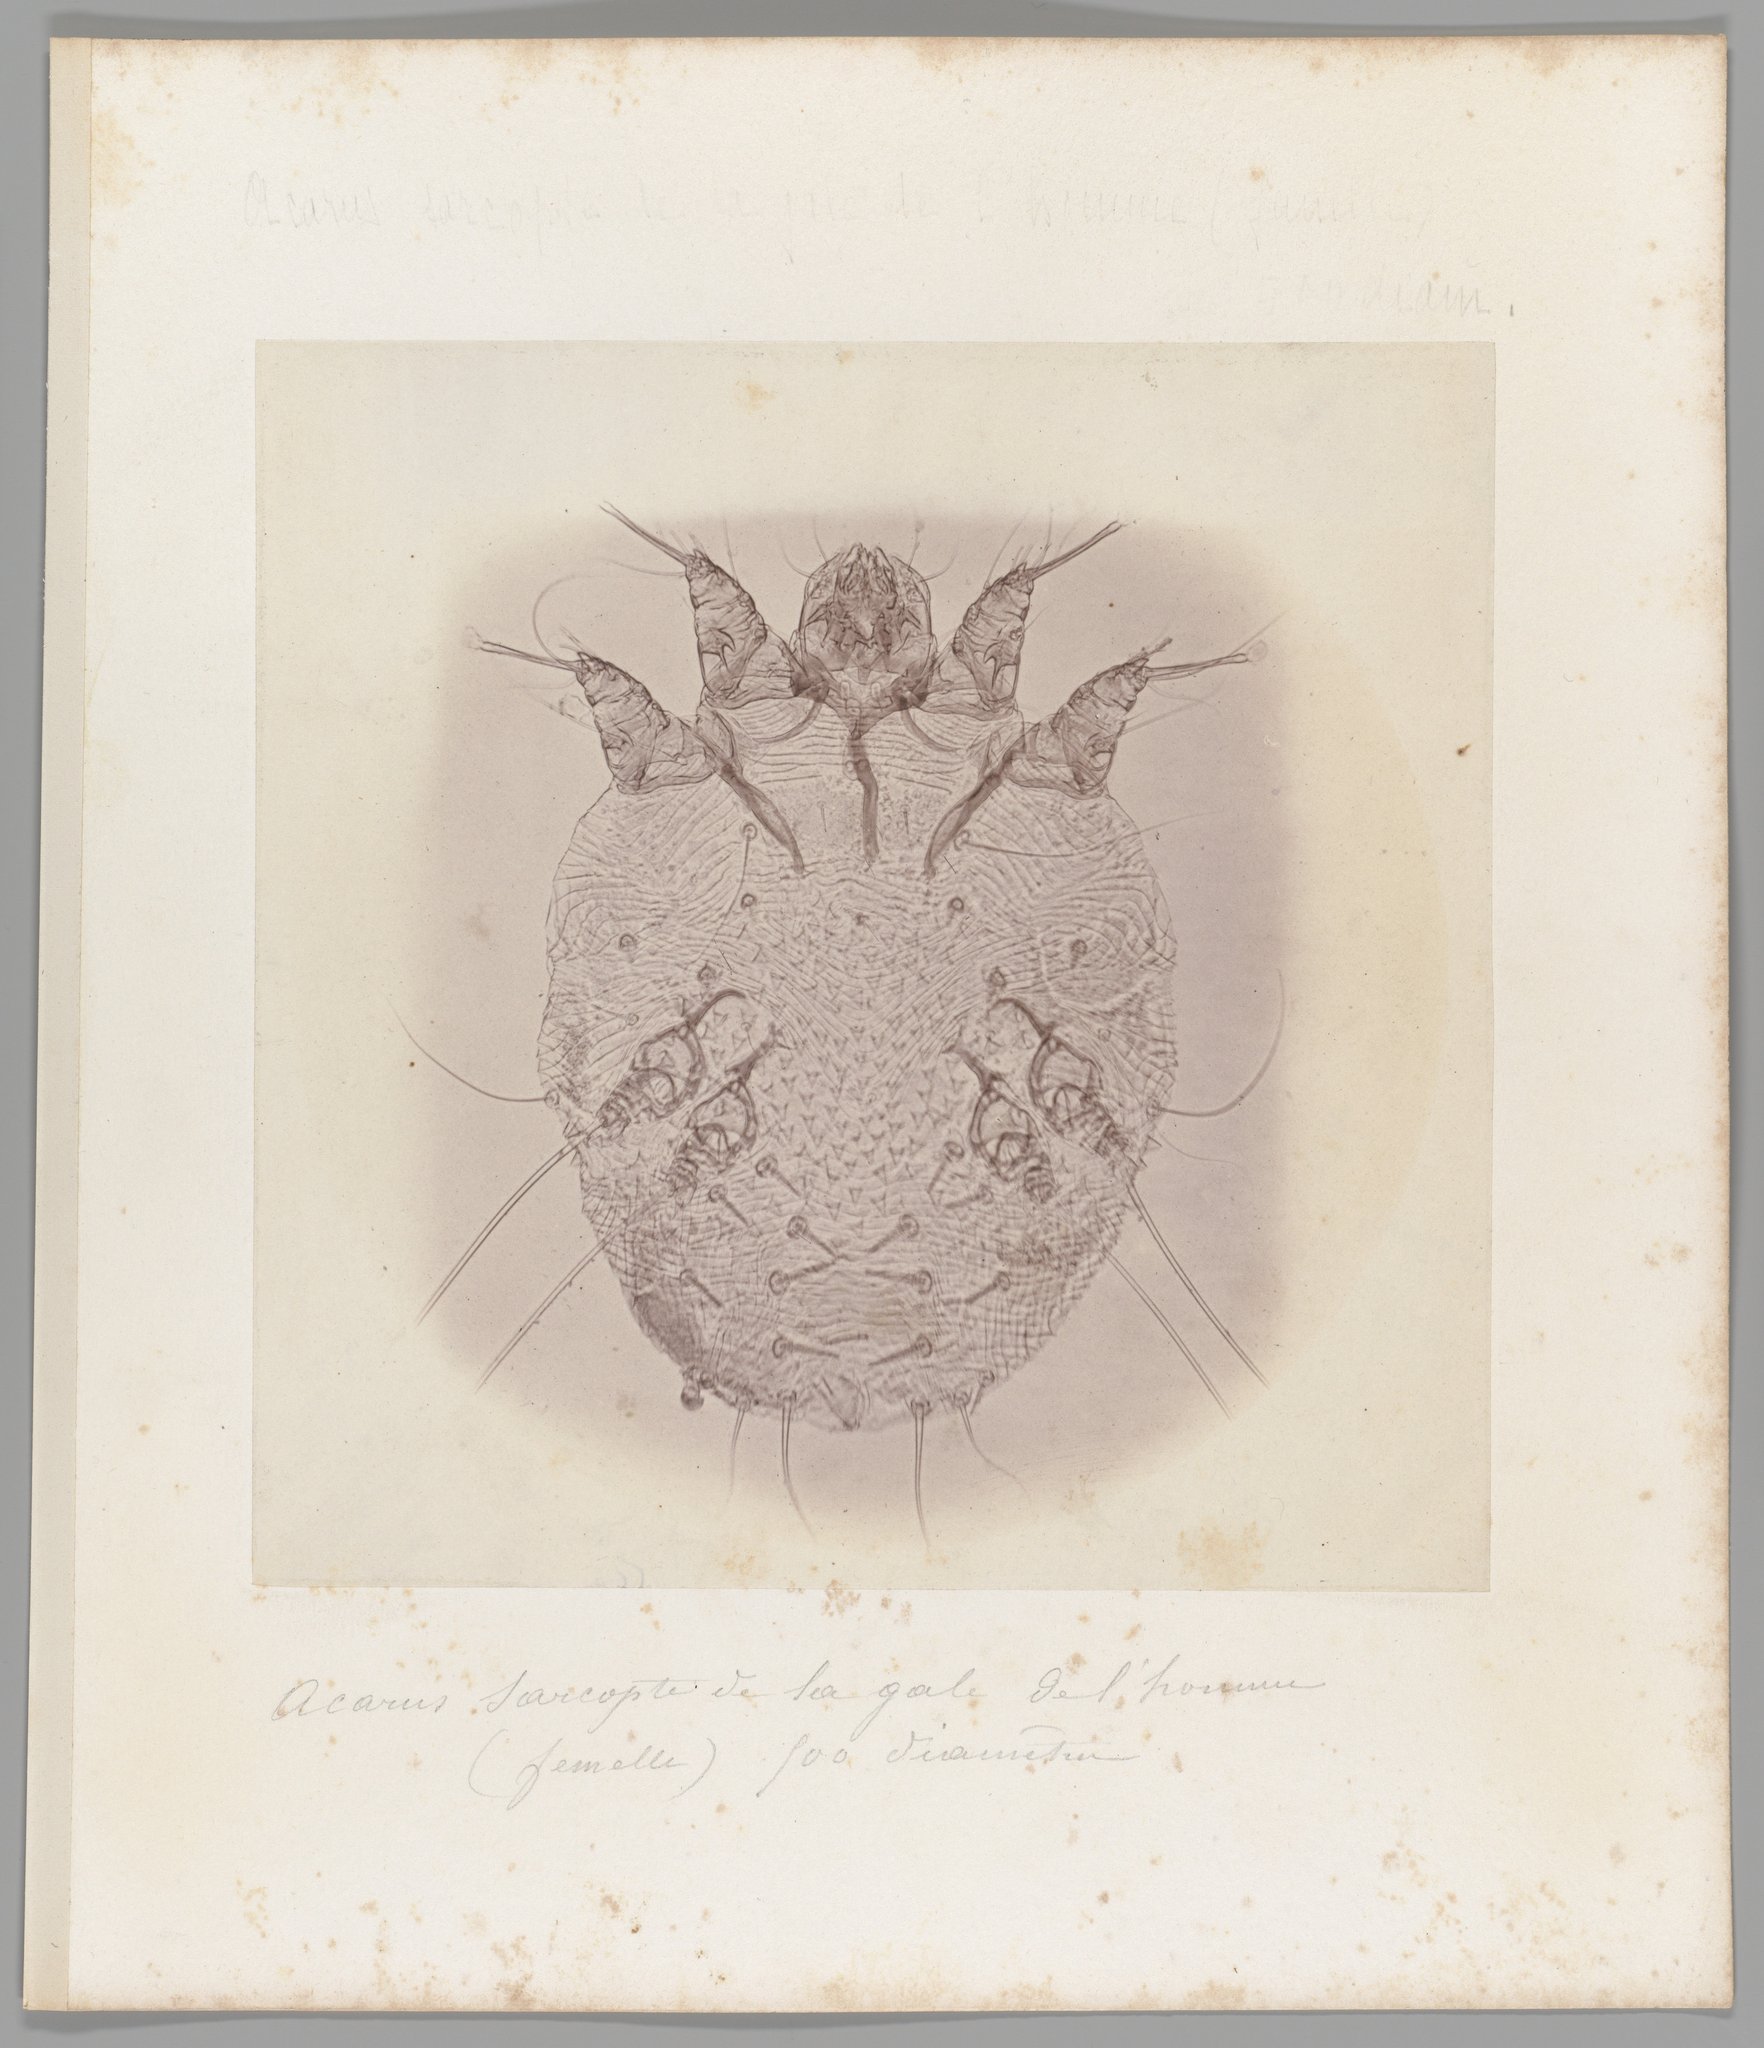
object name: photograph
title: [Untitled]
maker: auguste-adolphe bertsch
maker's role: artist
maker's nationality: french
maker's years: 1813-1871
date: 1853-1857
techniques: salted paper print